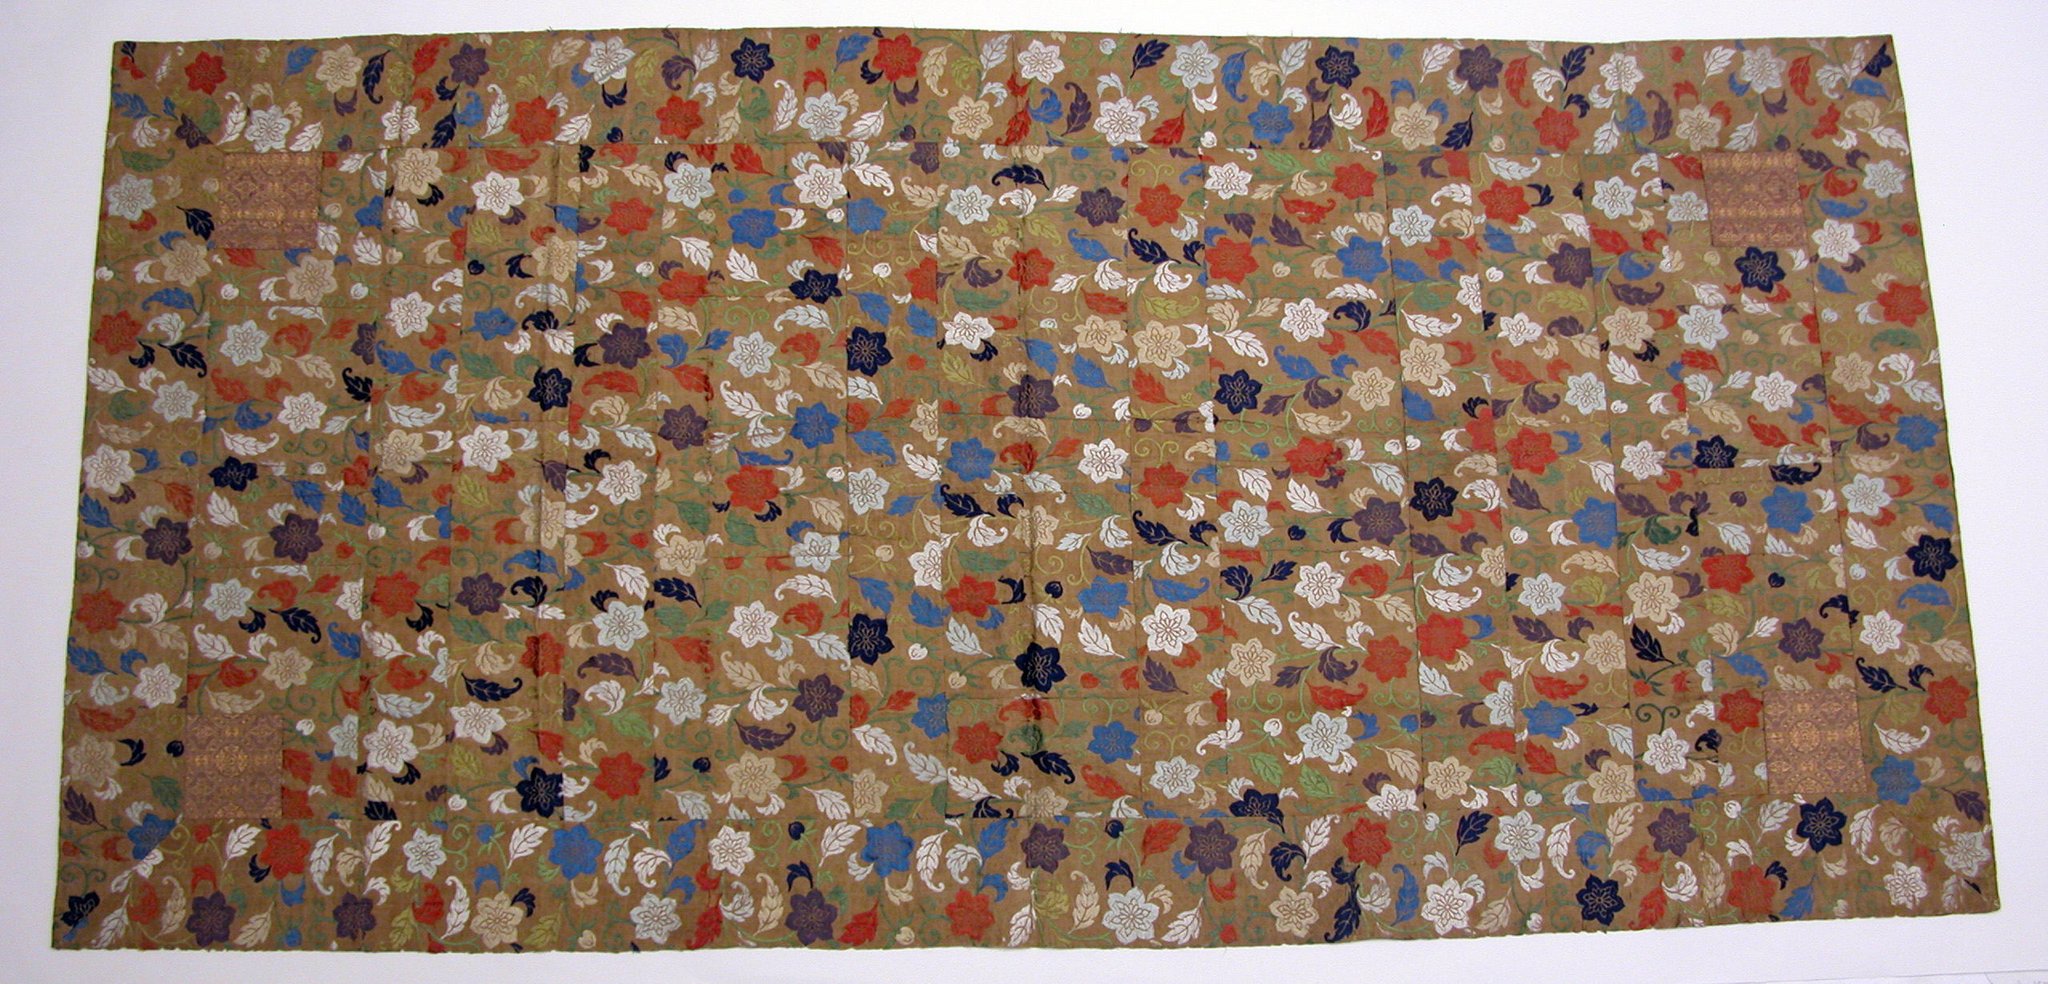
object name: robe, priest's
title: Buddhist Vestment (Kesa) with Clematis Flowers, Leaves, and Vines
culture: japanese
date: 1601-1700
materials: metal thread, silk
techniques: brocade, lampas, weave